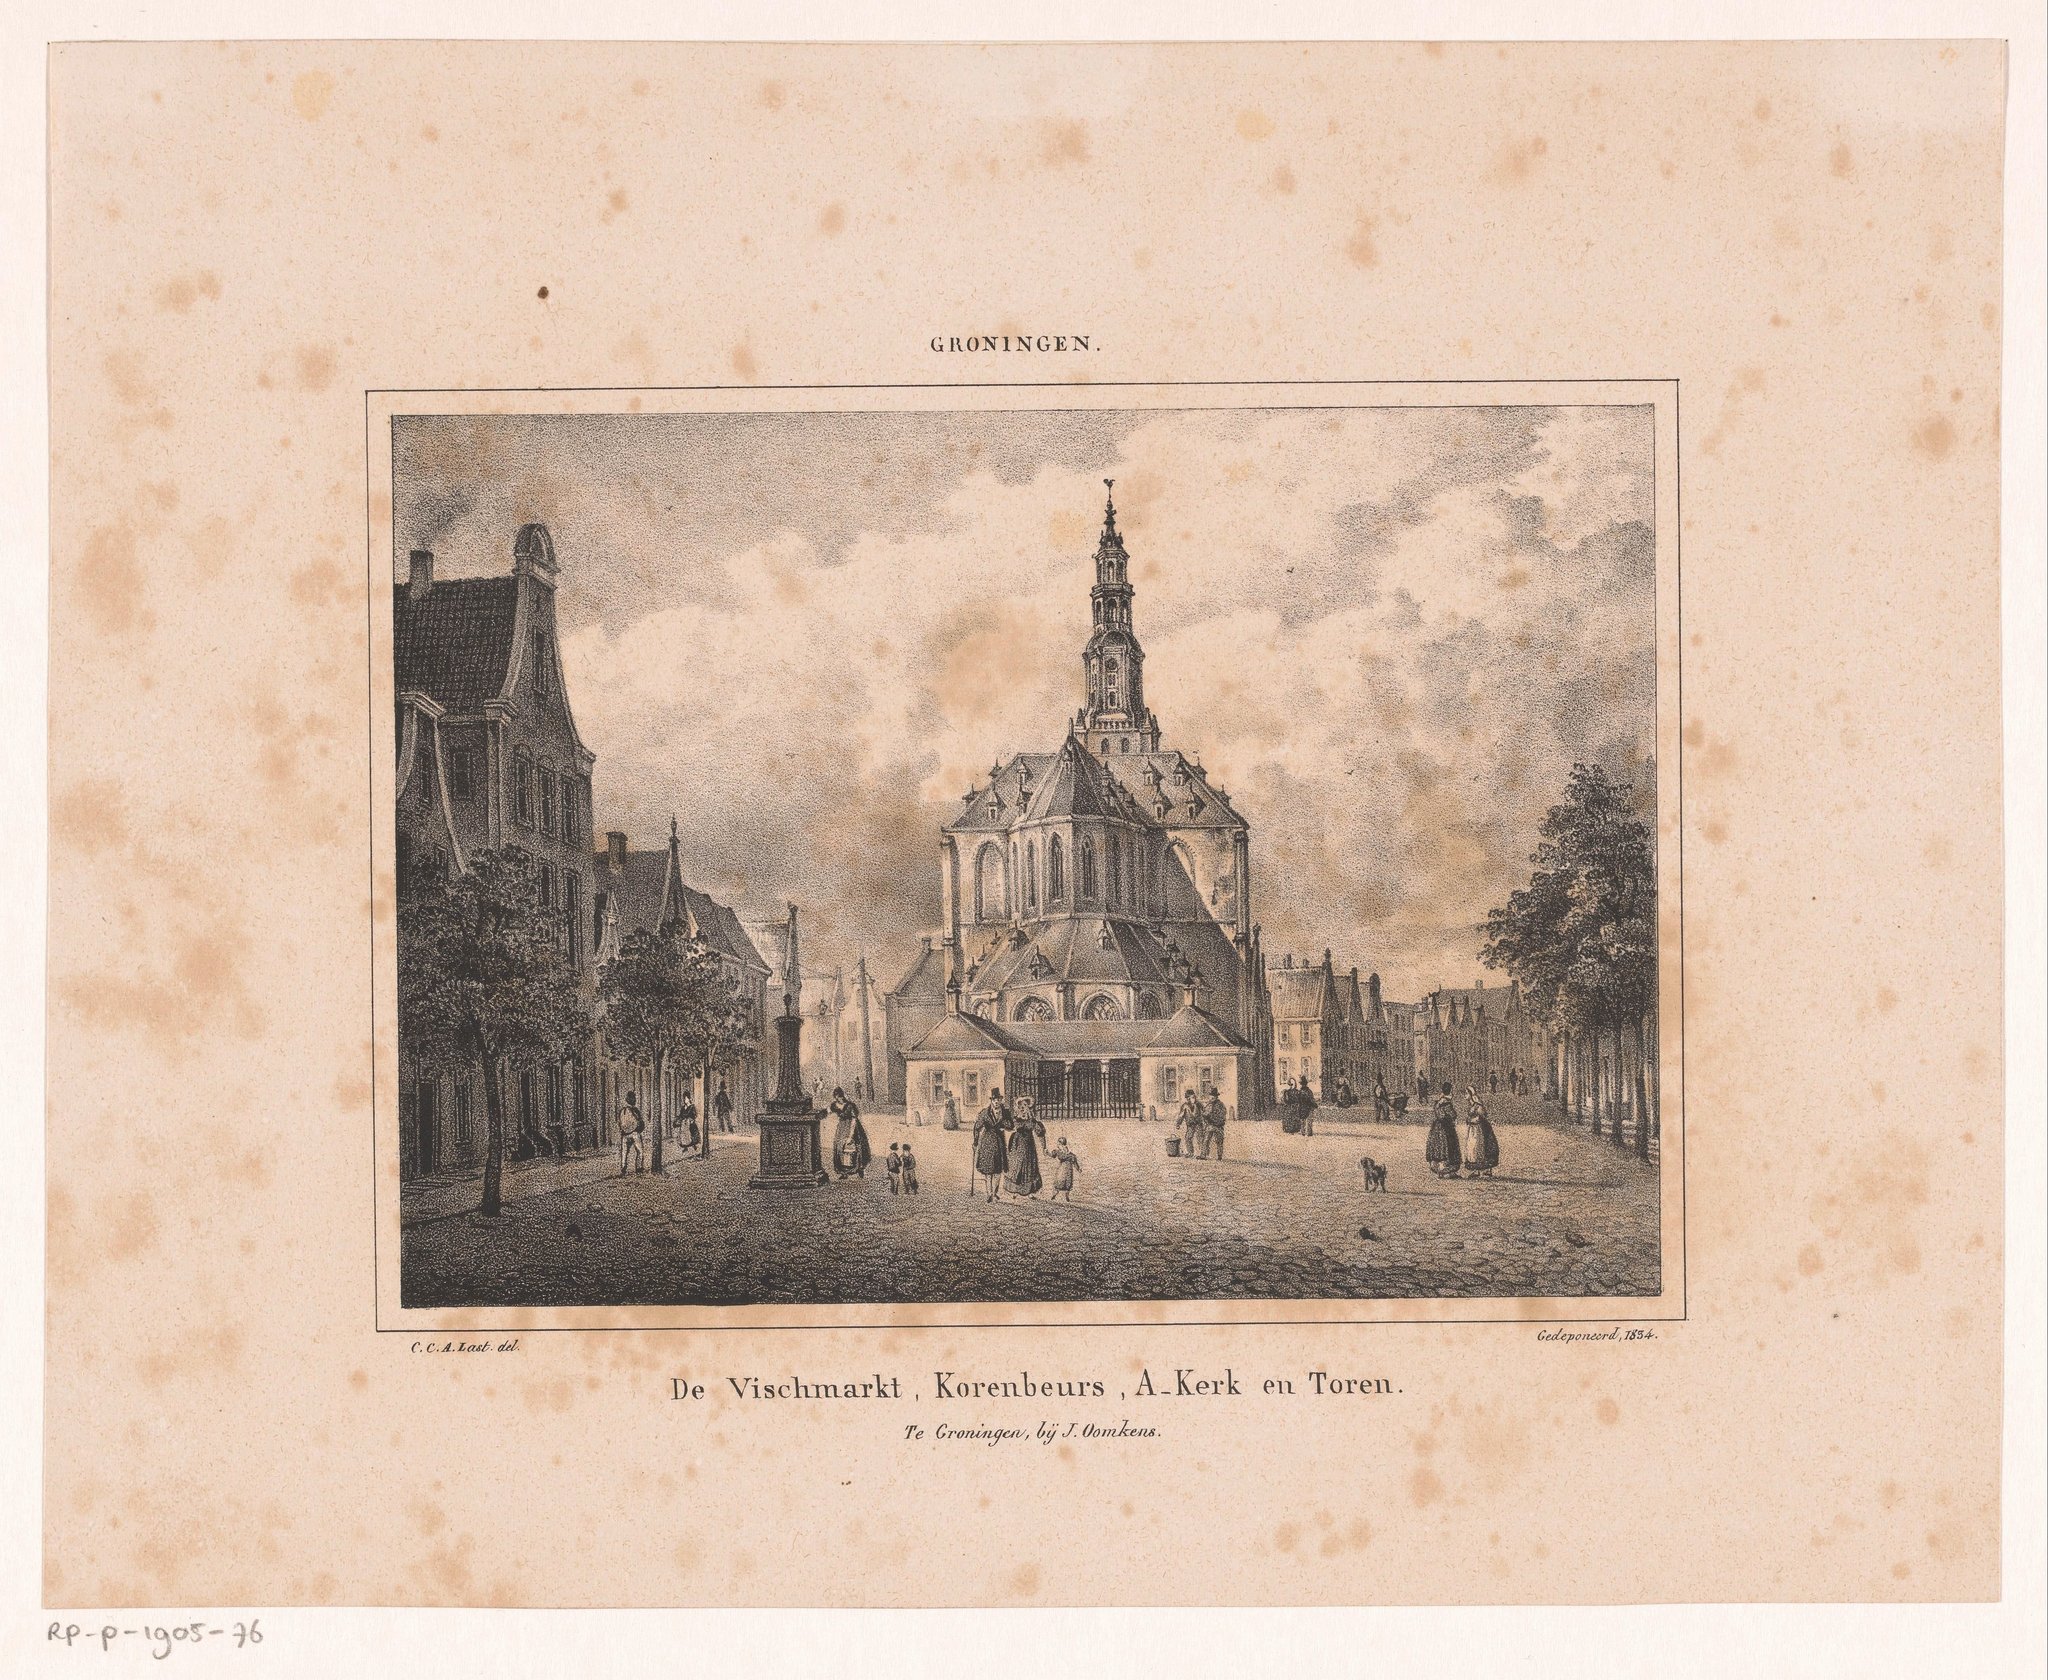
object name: print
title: Gezicht op de Der Aa-kerk en de vismarkt in Groningen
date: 1834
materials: paper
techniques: lithograph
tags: church (exterior), village square, place (+ city(-scape) with figures, staffage)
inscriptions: : ‘Gedeponeerd 1834.’, collector's mark: Lugt 2228